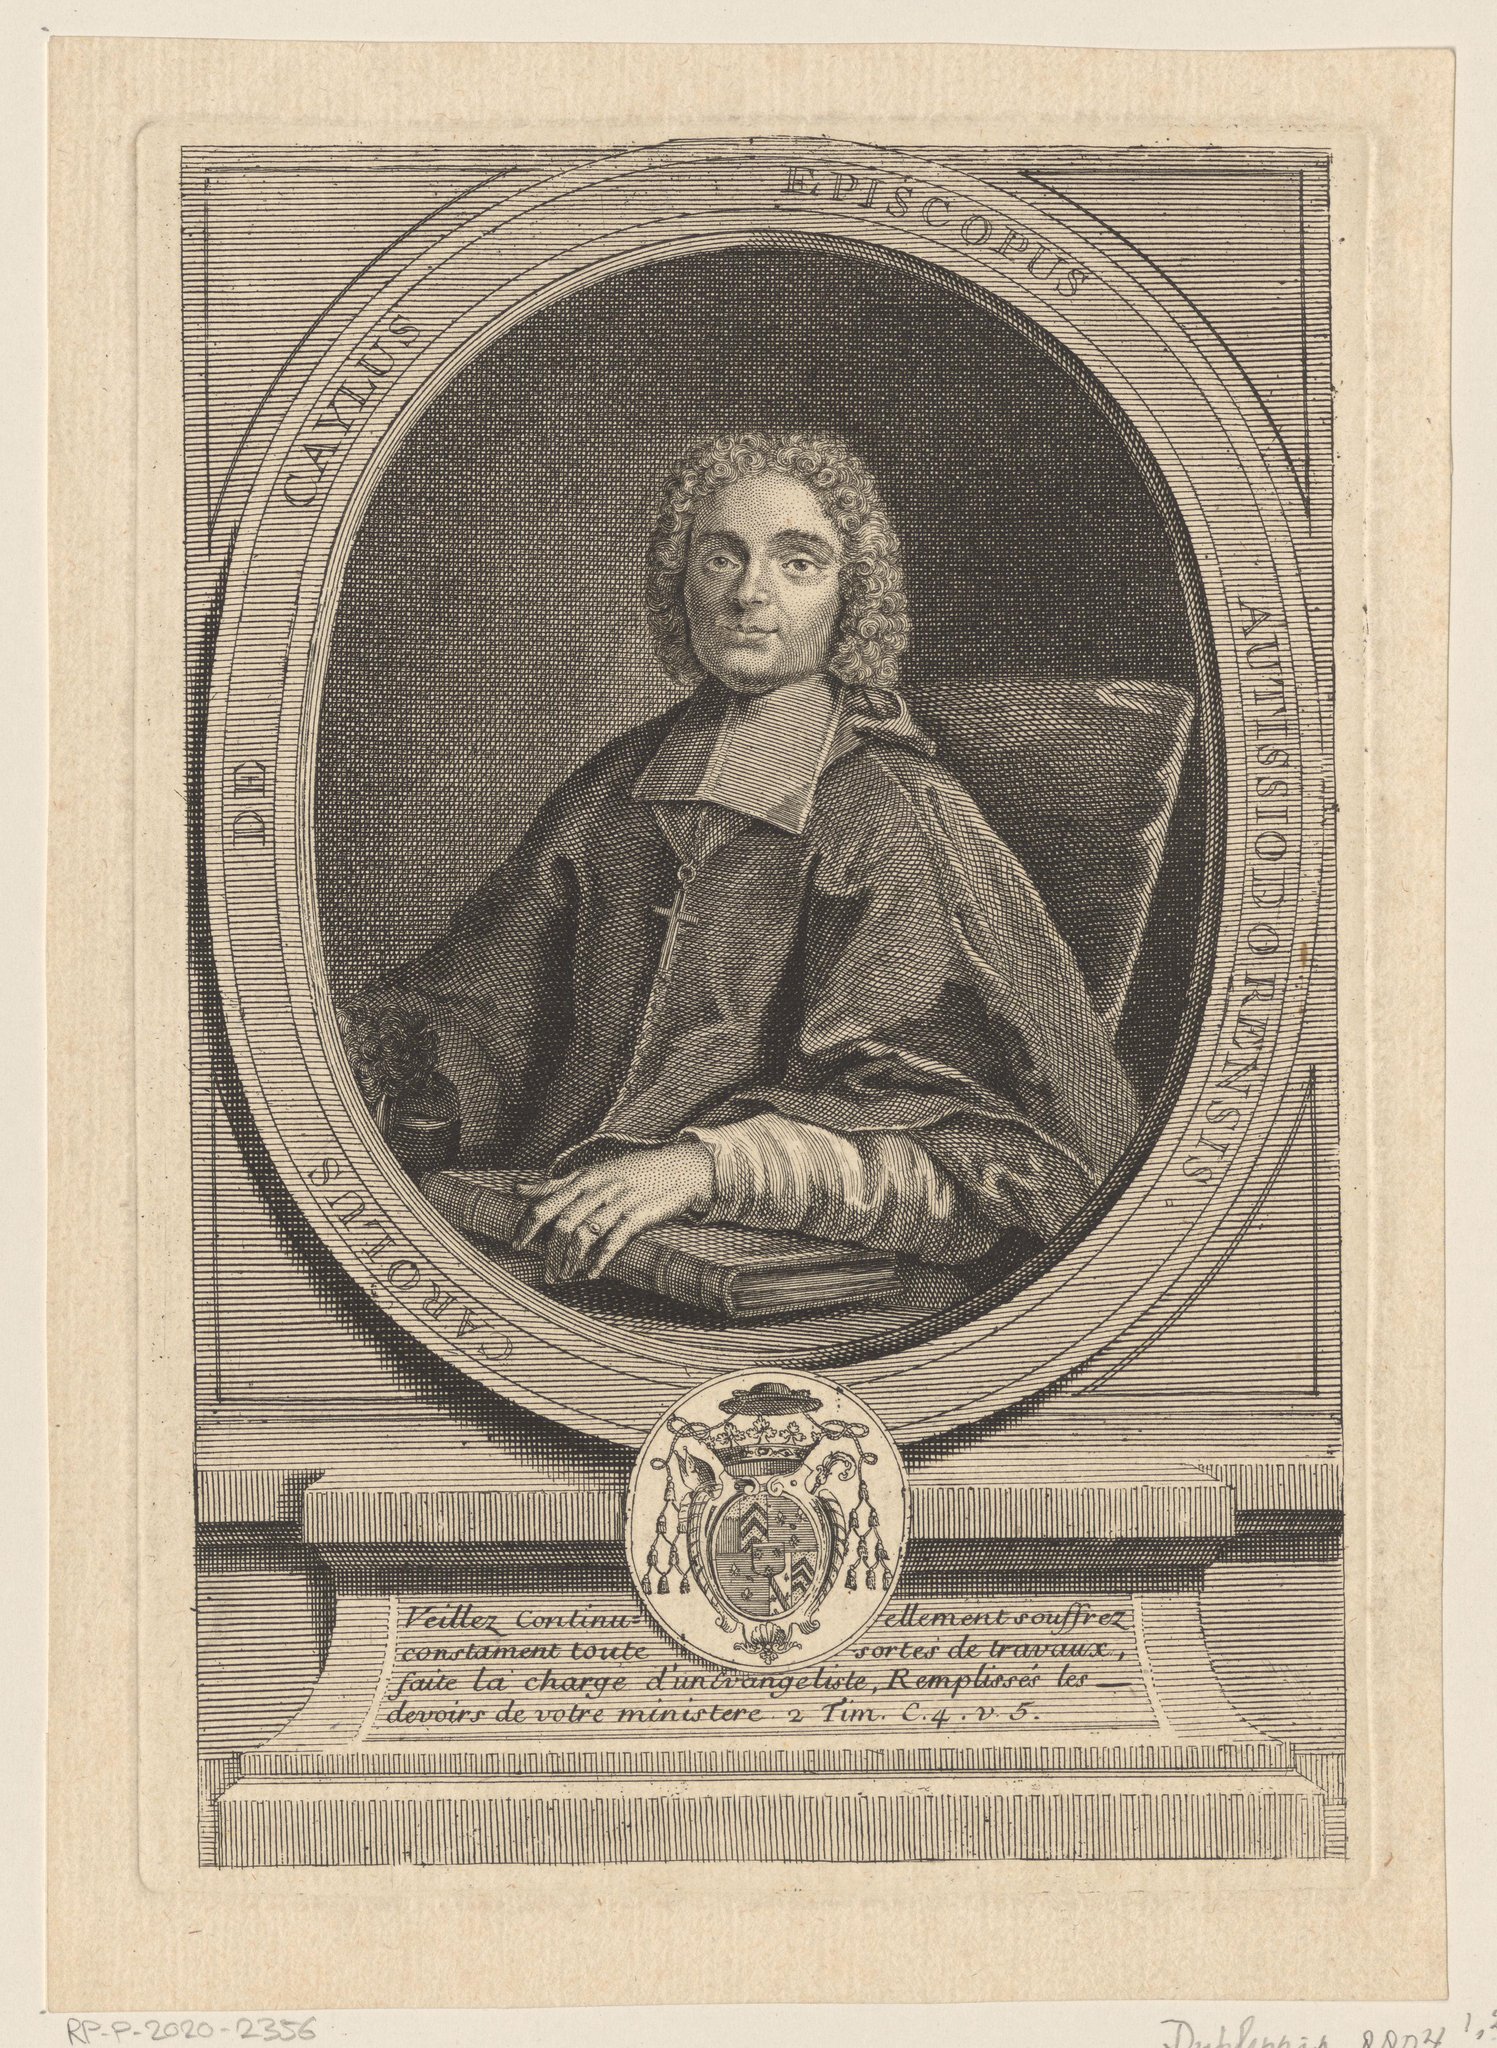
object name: print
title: Portret van Daniel-Charles-Gabriel de Tubières de Caylus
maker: Anonymous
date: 1700-1760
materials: paper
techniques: engraving, etching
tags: historical persons, armorial bearing, heraldry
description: Onder de geportretteerde zijn wapenschild.